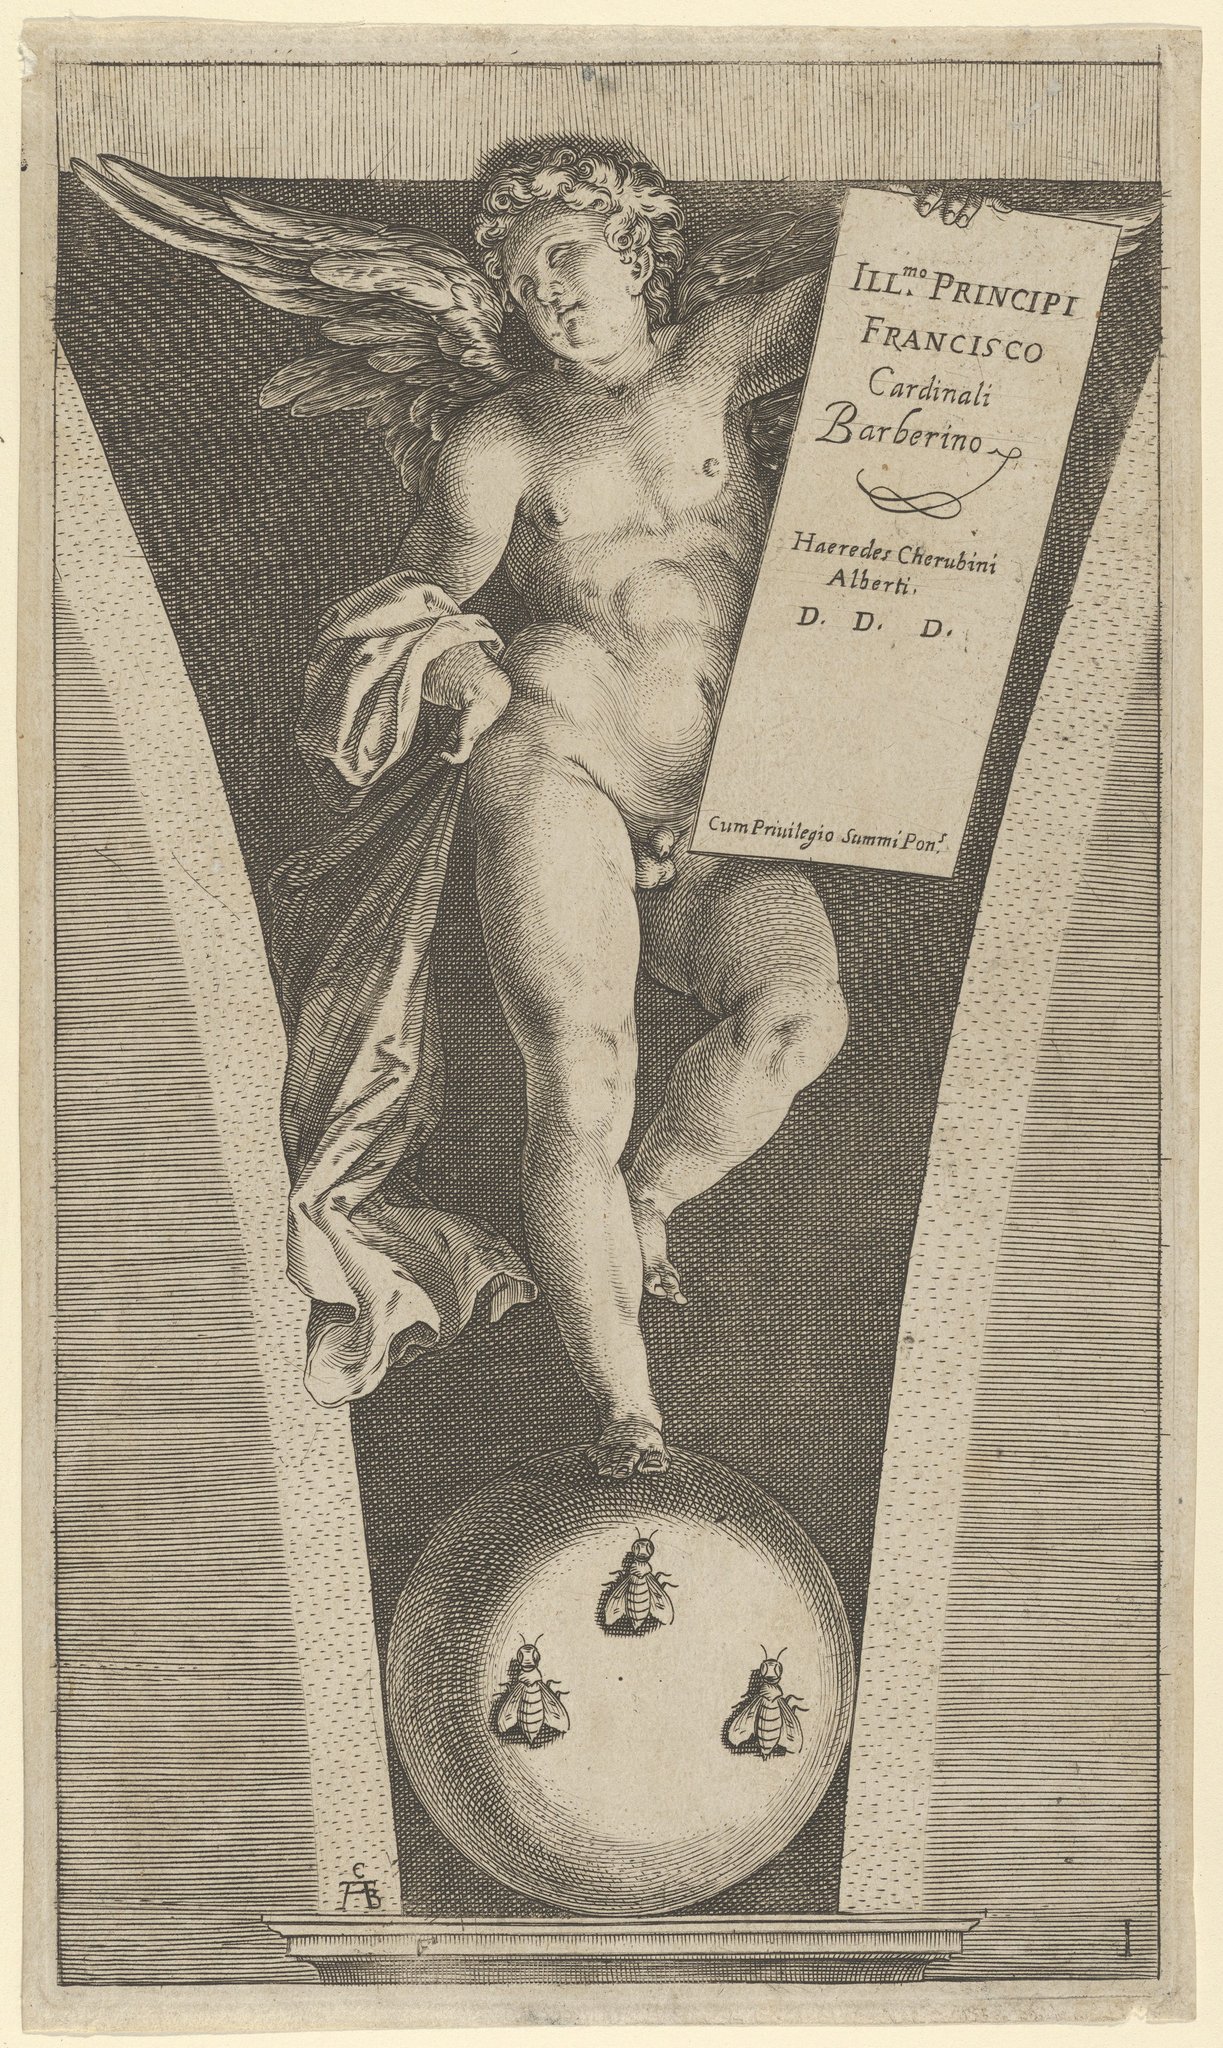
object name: print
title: Winged genius holding a tableau, standing on a sphere with three bees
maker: cherubino alberti (zaccaria mattia)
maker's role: artist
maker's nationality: italian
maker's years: 1553-1615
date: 1570-1615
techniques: engraving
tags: bees